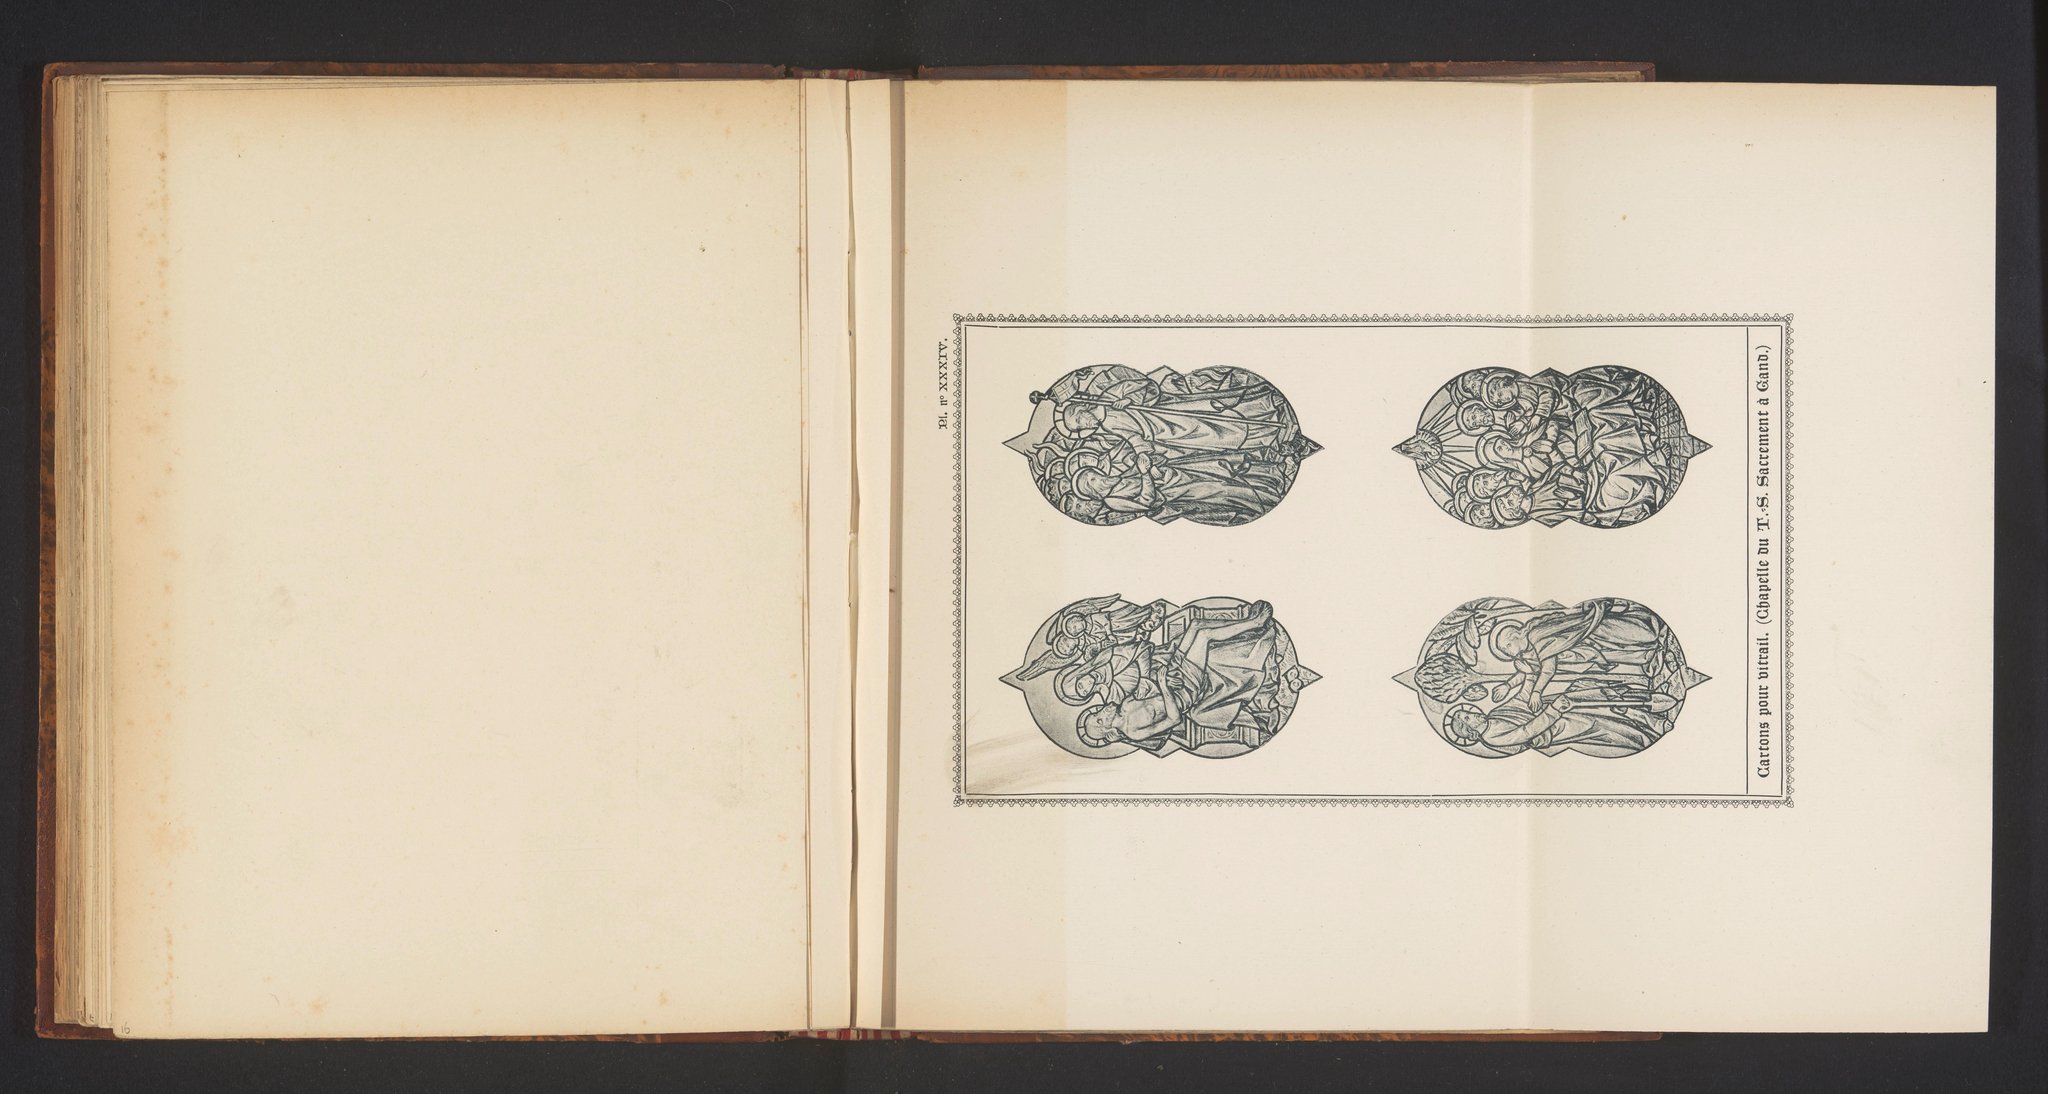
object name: photomechanical print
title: Cartons pour vitrail. (Chapelle du T.S. Sacrement à Gand.)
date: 1891-1896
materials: paper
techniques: autotype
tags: church-window, e.g. rose-window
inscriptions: number: ‘Pl. no XXXIV.’